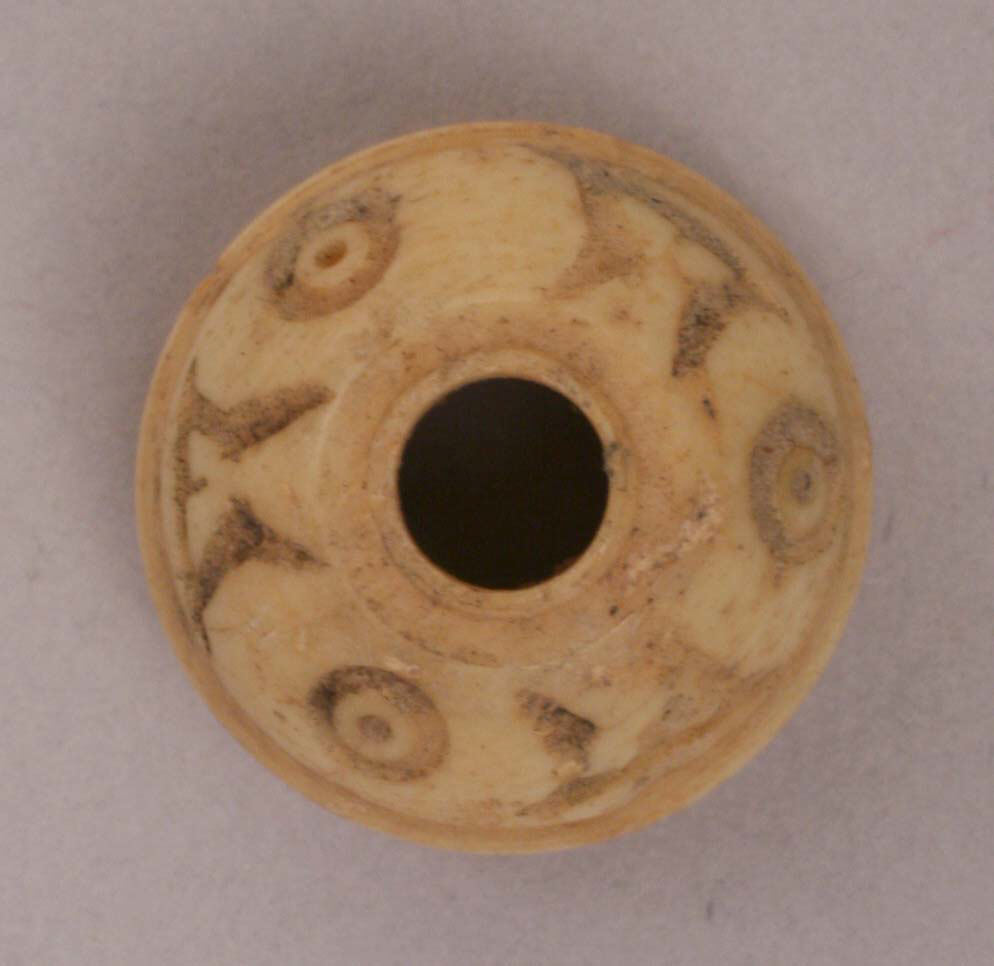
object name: button or bead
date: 801-1000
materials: bone, paint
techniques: incising, inlay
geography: iran